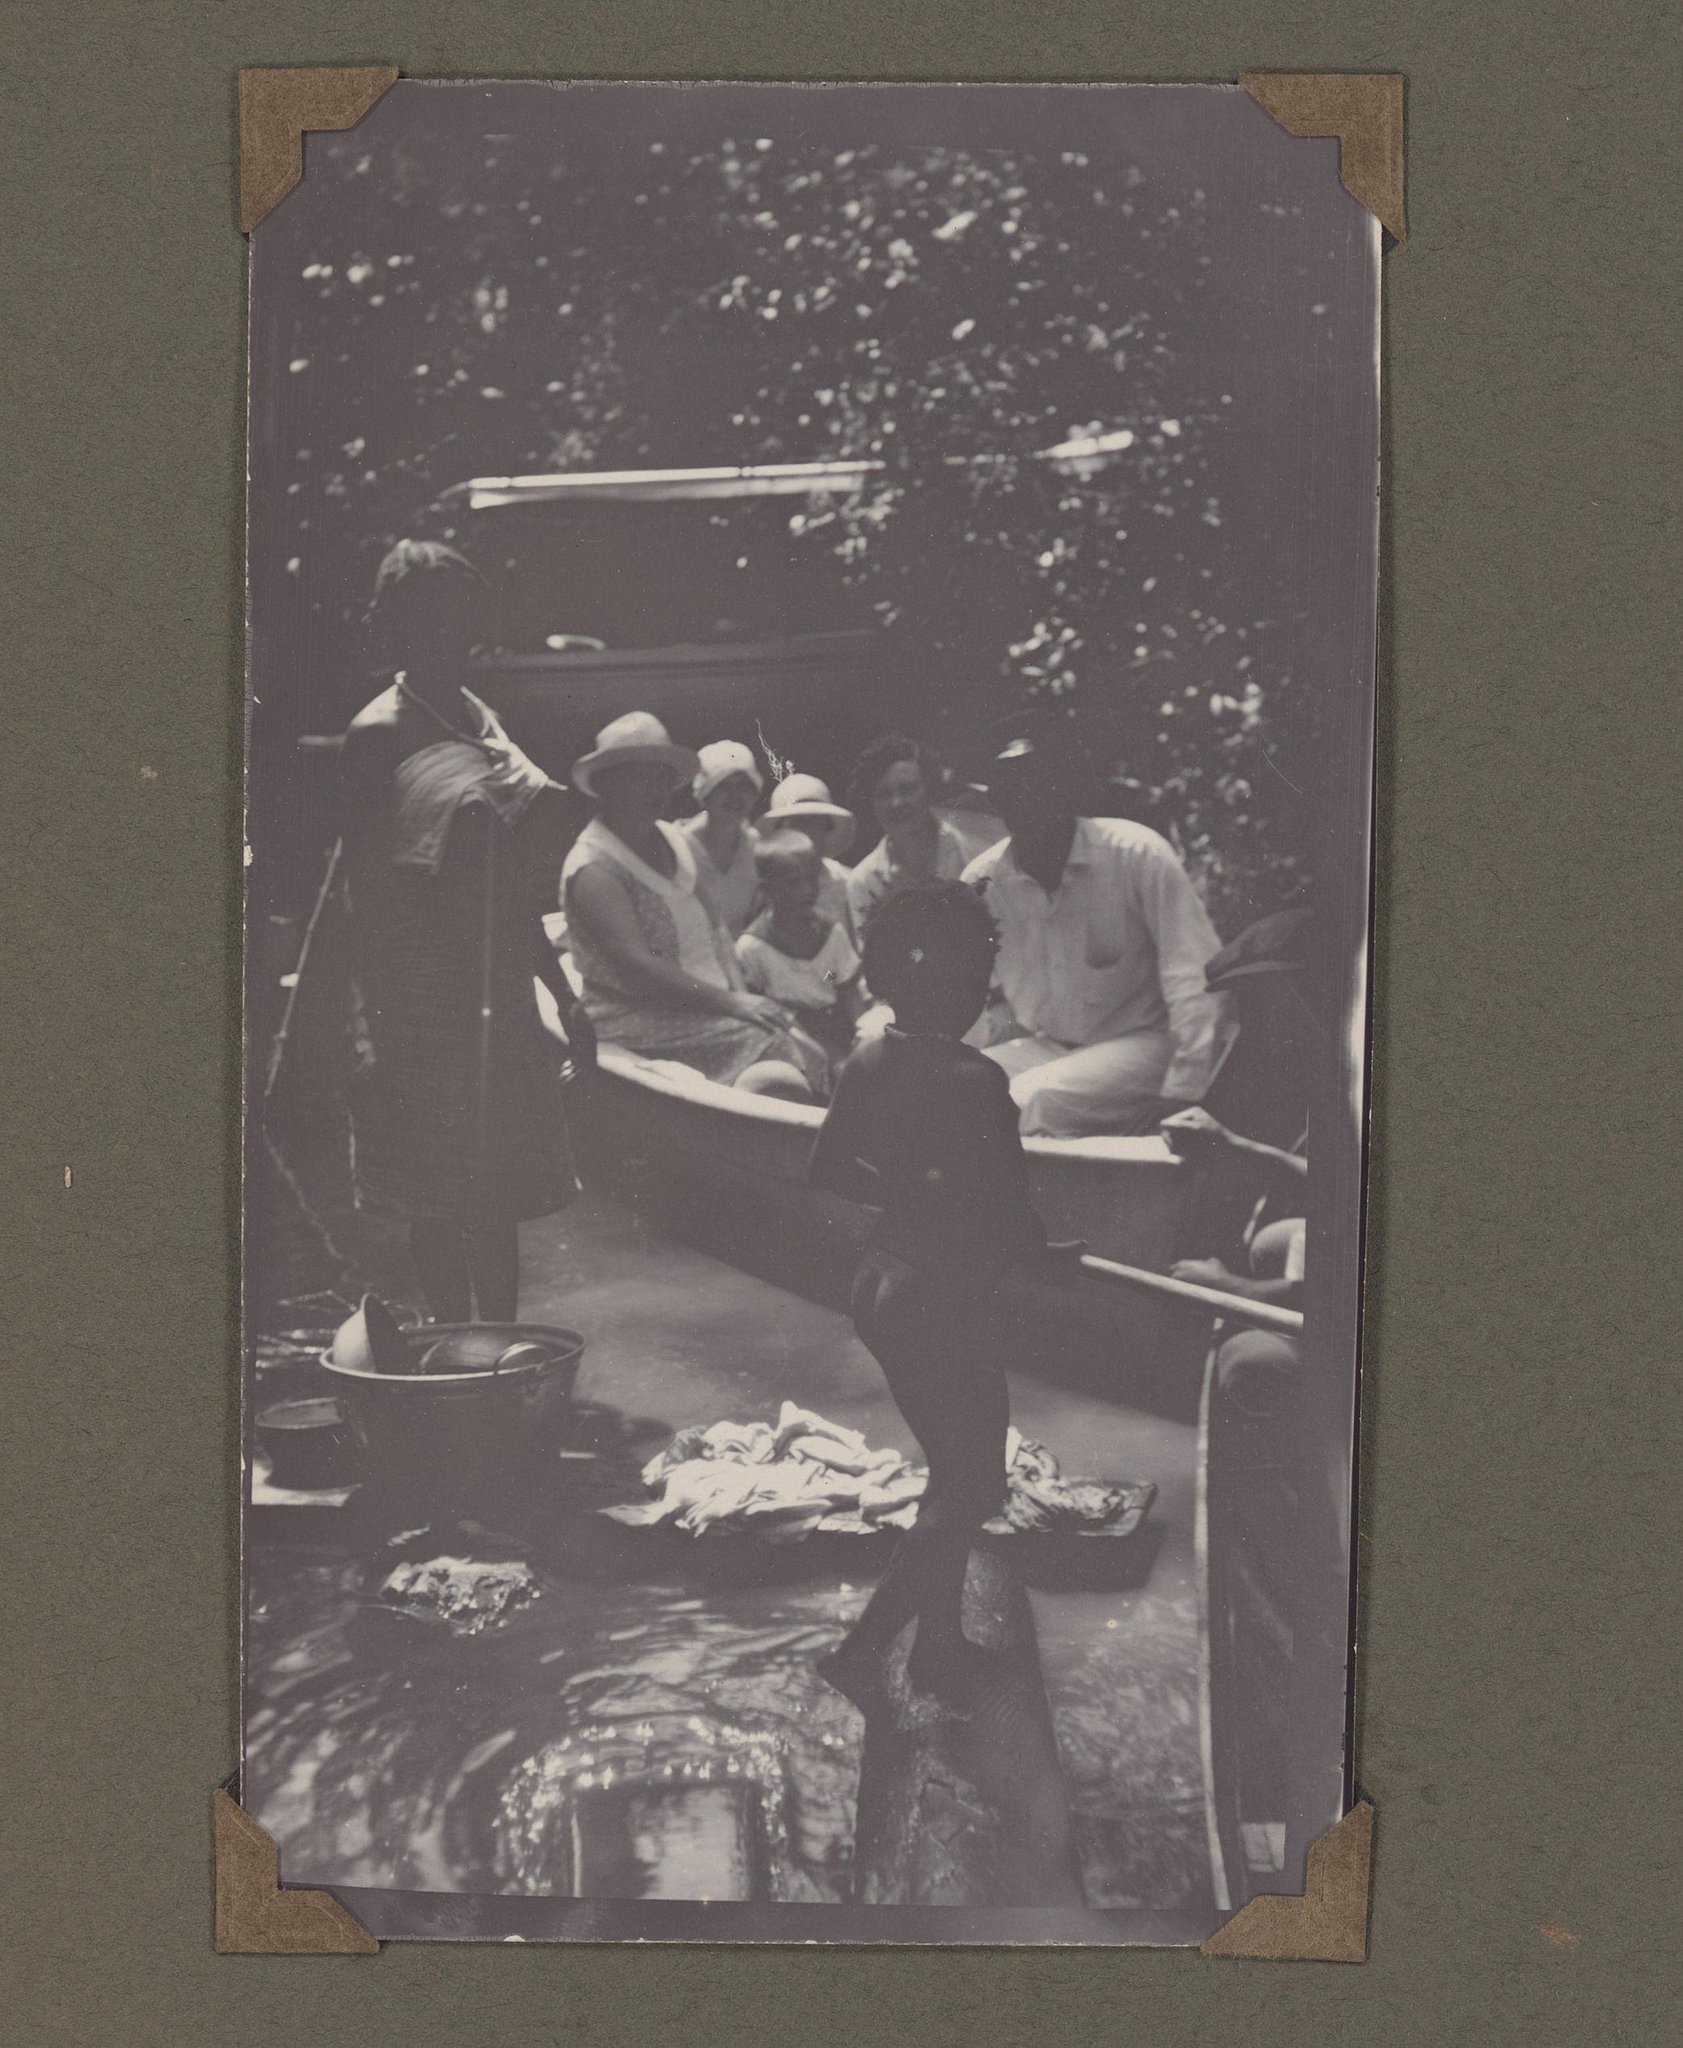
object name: photograph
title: Boottochtje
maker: Anonymous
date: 1925-1927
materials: photographic support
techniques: photography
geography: suriname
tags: jetten, familie, moengo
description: Boottochtje langs wassende dorpelingen. Foto op een bladzijde van een los albumblad. Onderdeel van het ensemble met foto's van de familie van ingenieur Jetten in de mijnbouwstad Moengo in Suriname.